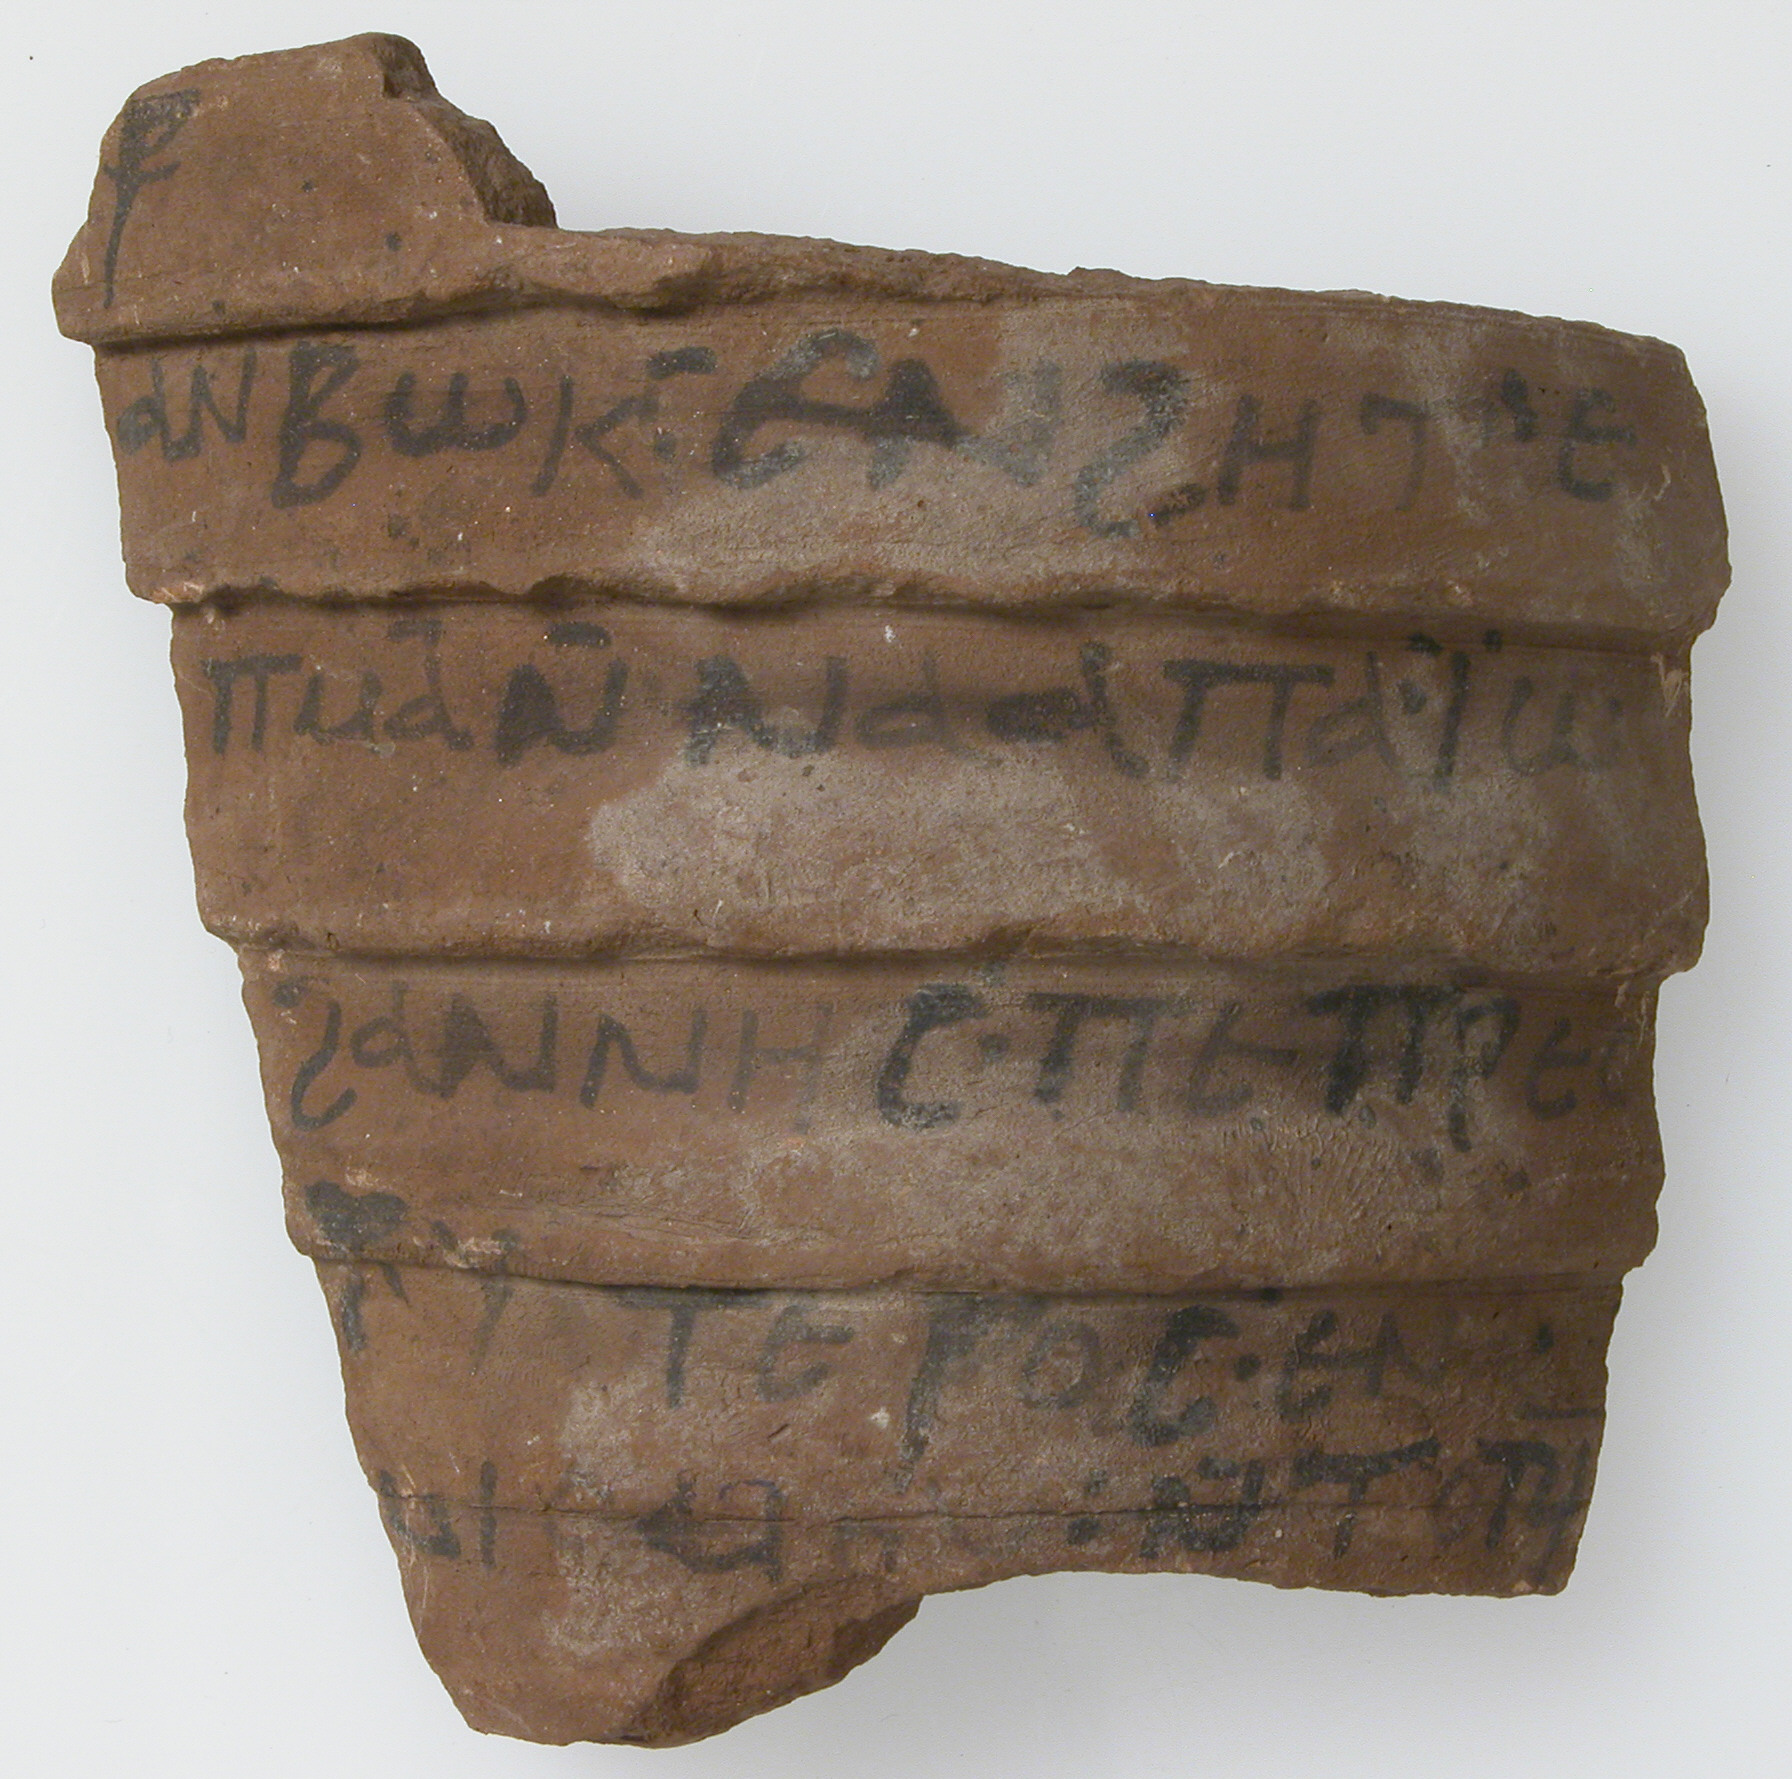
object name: ostrakon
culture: coptic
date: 601-700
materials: ink, pottery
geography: egypt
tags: coptic